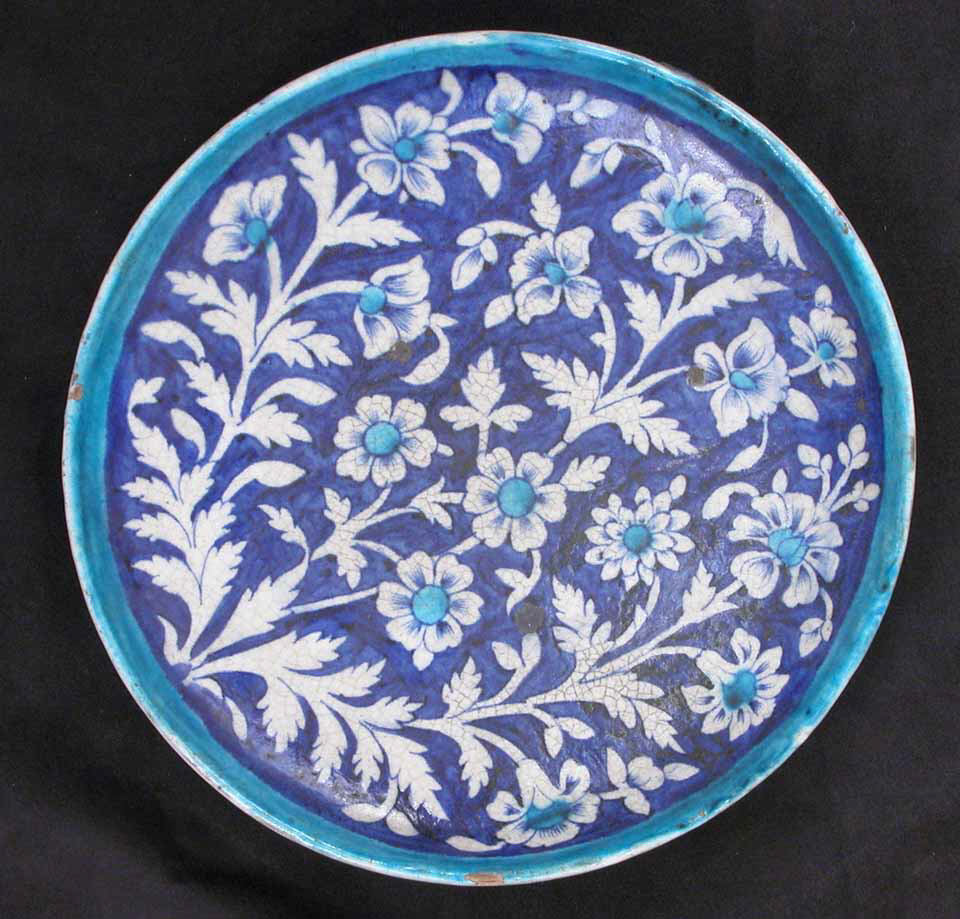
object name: dish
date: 1701-1800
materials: earthenware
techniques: glazing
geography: pakistan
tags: flowers,leaves